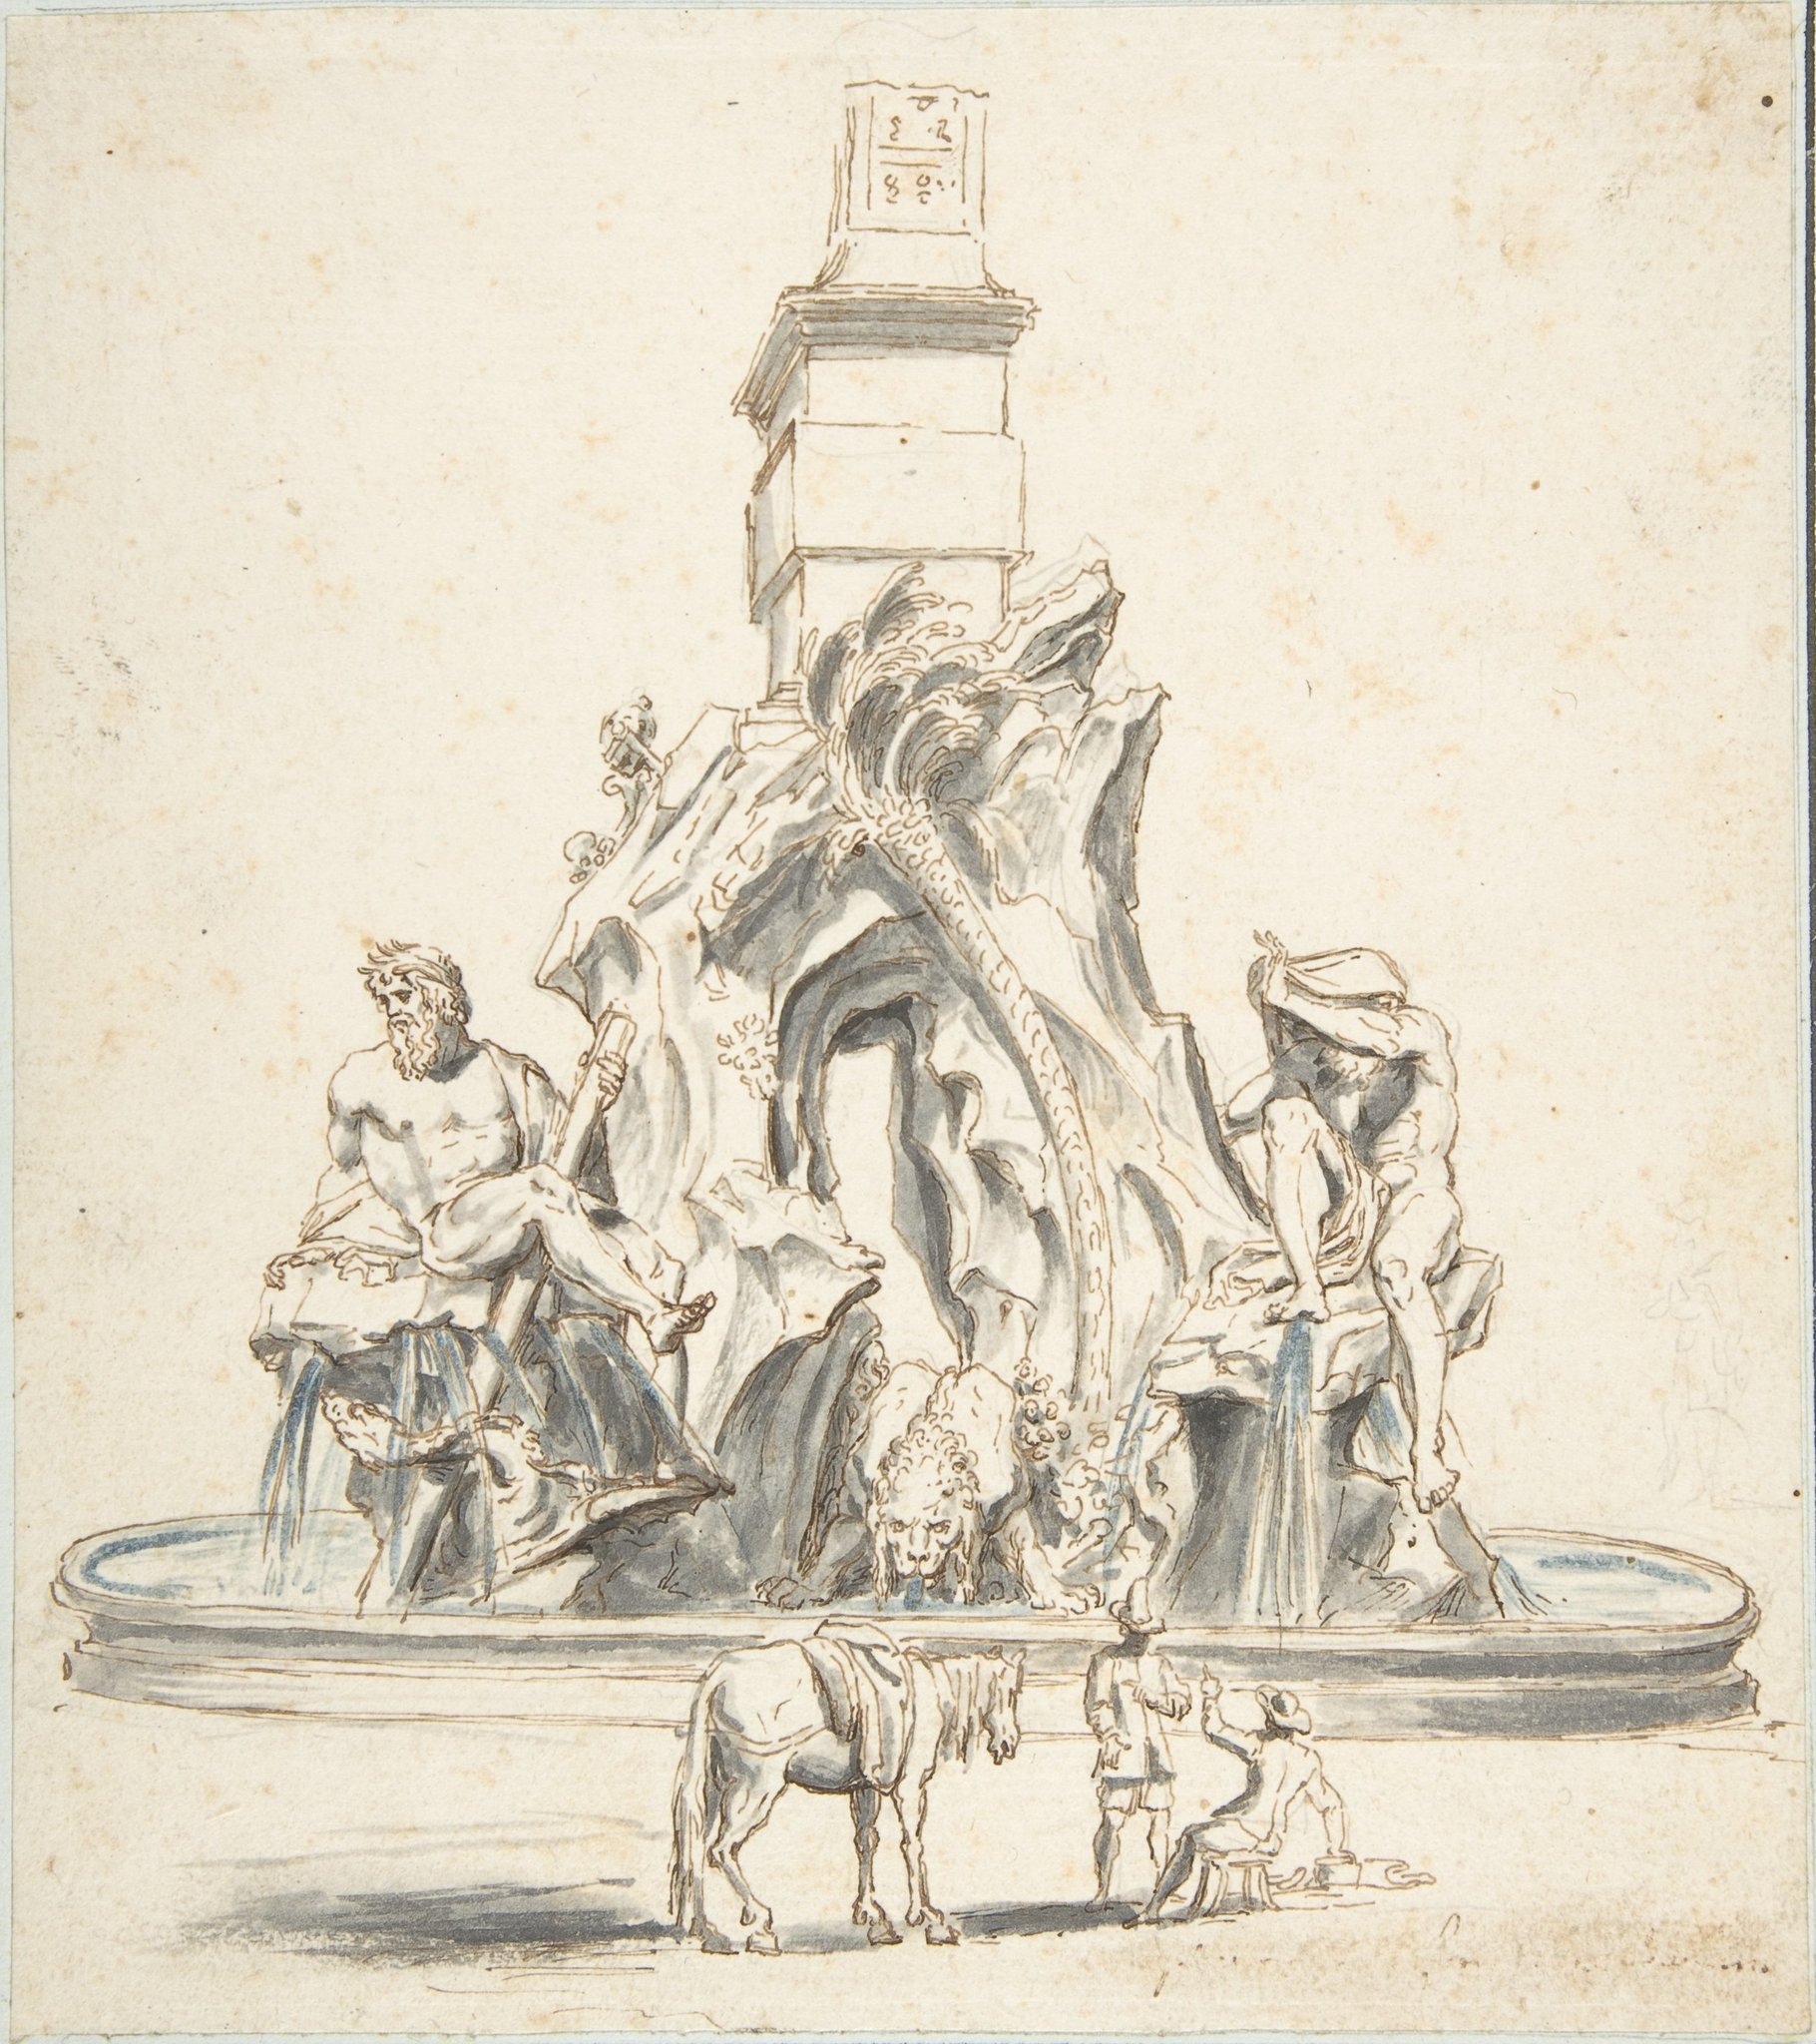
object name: drawing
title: Bernini's Fountain of the Four Rivers in Piazza Navona, Rome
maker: anonymous, italian, 18th century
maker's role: artist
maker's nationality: italian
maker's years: 1700-1800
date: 1701-1800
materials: graphite, ink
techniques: brush, pen, wash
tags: fountains,male nudes,horses